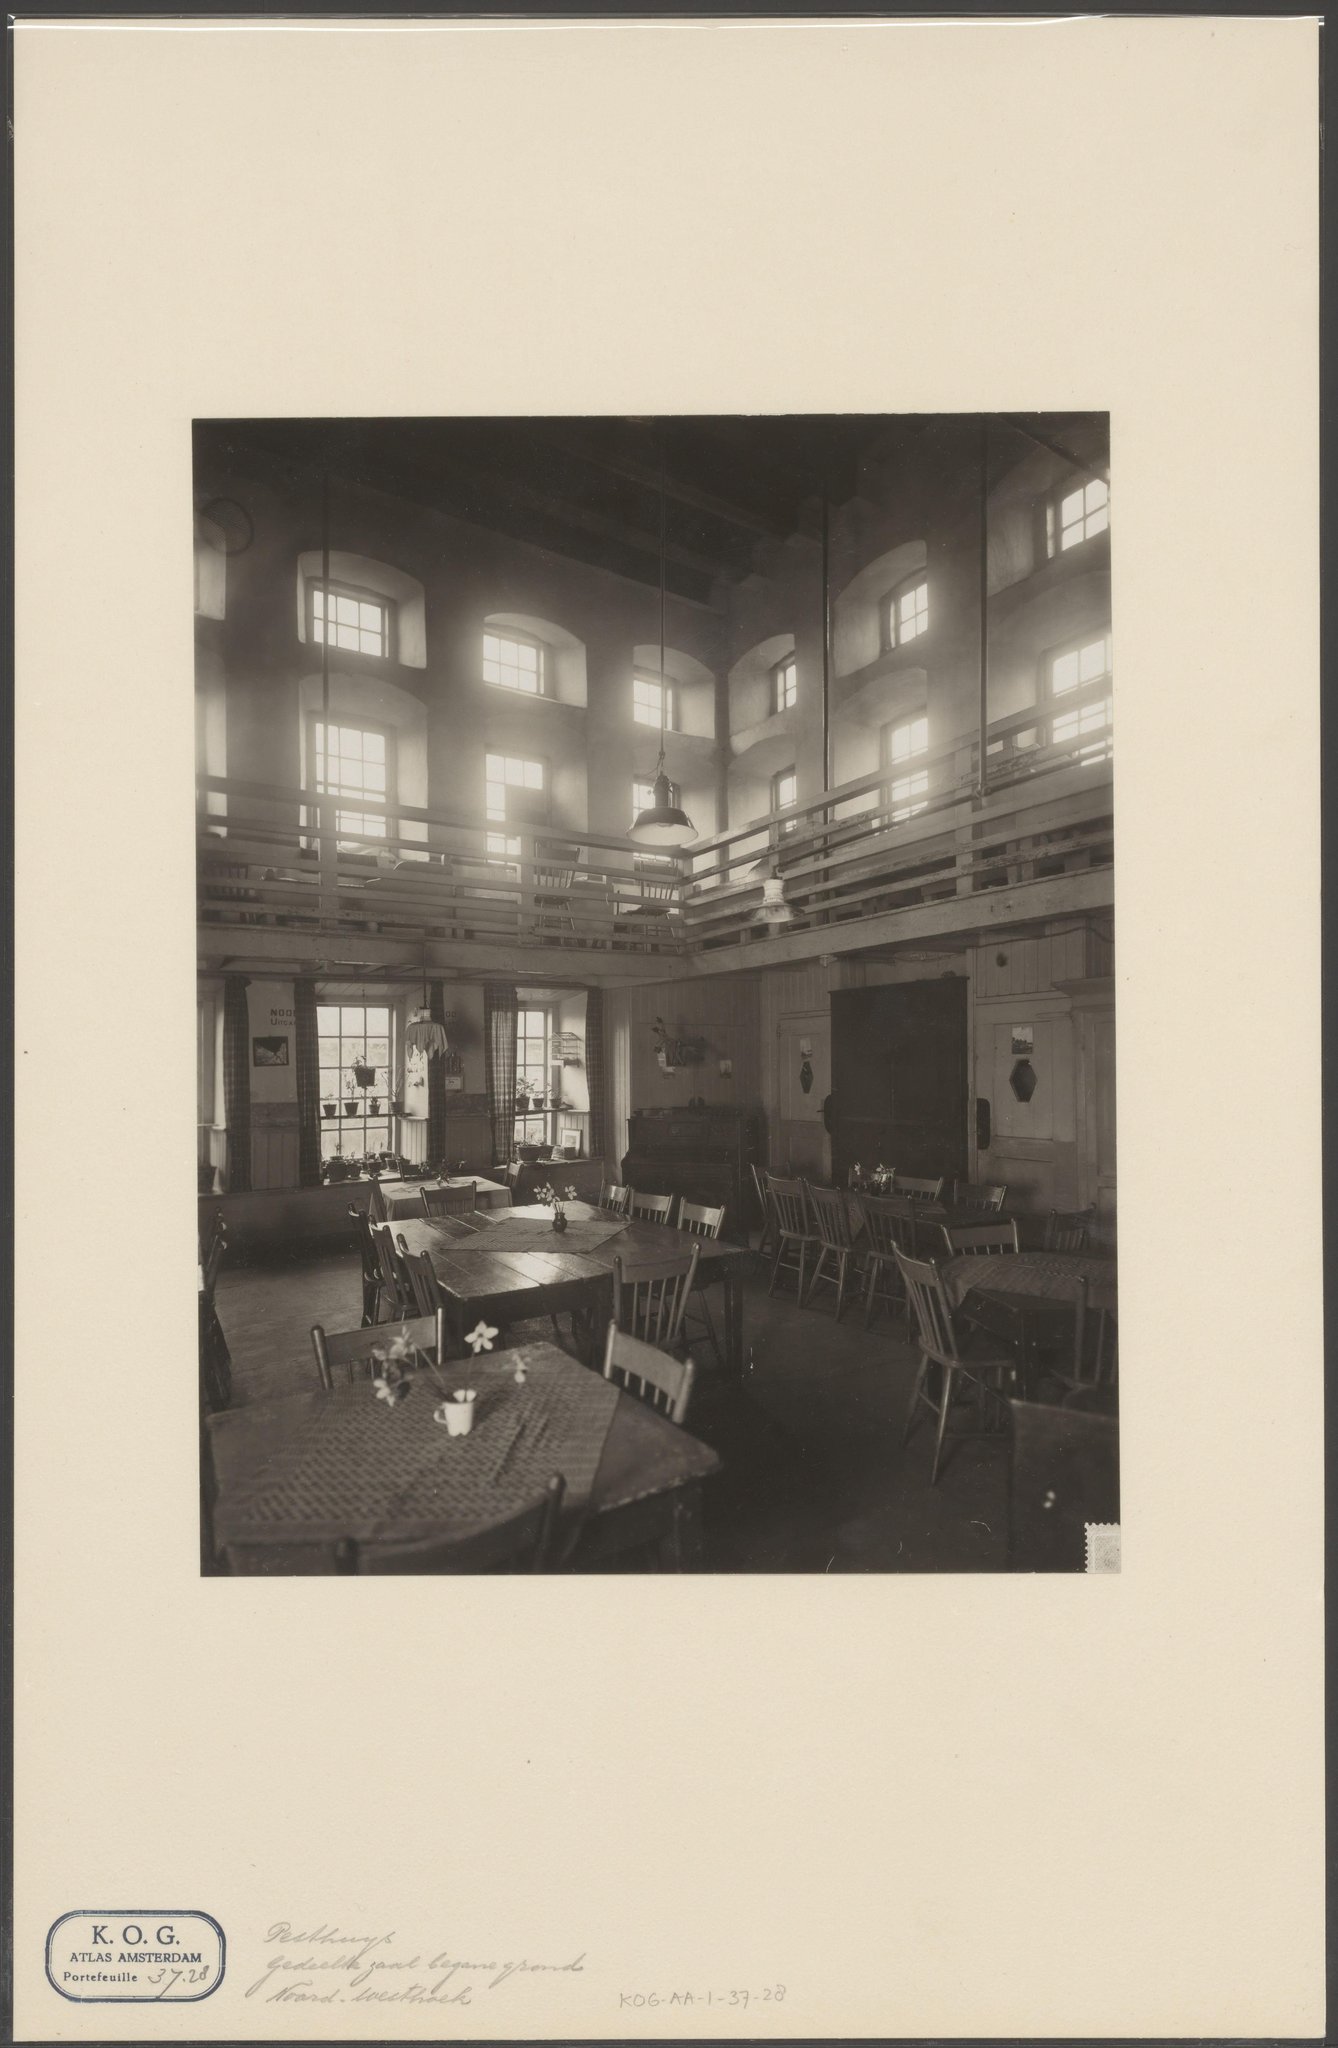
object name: photograph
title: Gemeenschappelijke ruimte op de benedenverdieping van het Buitengasthuis te Amsterdam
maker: Anonymous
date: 1931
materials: paper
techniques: gelatin silver print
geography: amsterdam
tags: hospital, communal rooms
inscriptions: collector's mark: Lugt 1641b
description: Onderwerpsrubriek binnen de Atlas Amsterdam: Armwezen en liefdadige instellingen: I. Stadsinrichtingen: Buitengasthuis (Pesthuis).